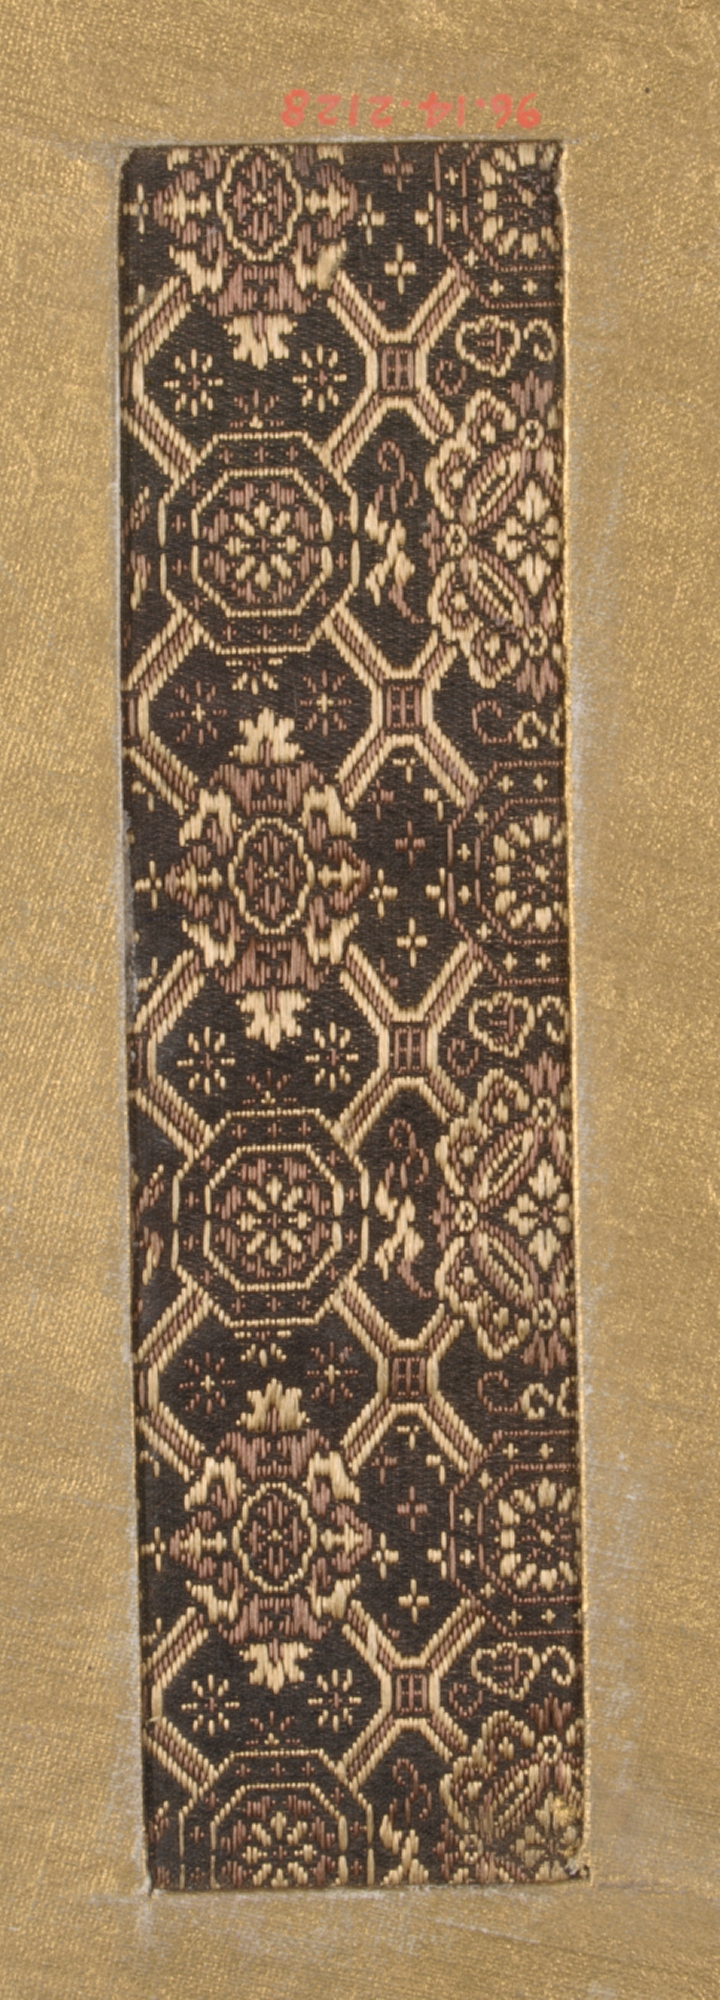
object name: piece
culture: japanese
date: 1701-1900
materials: silk